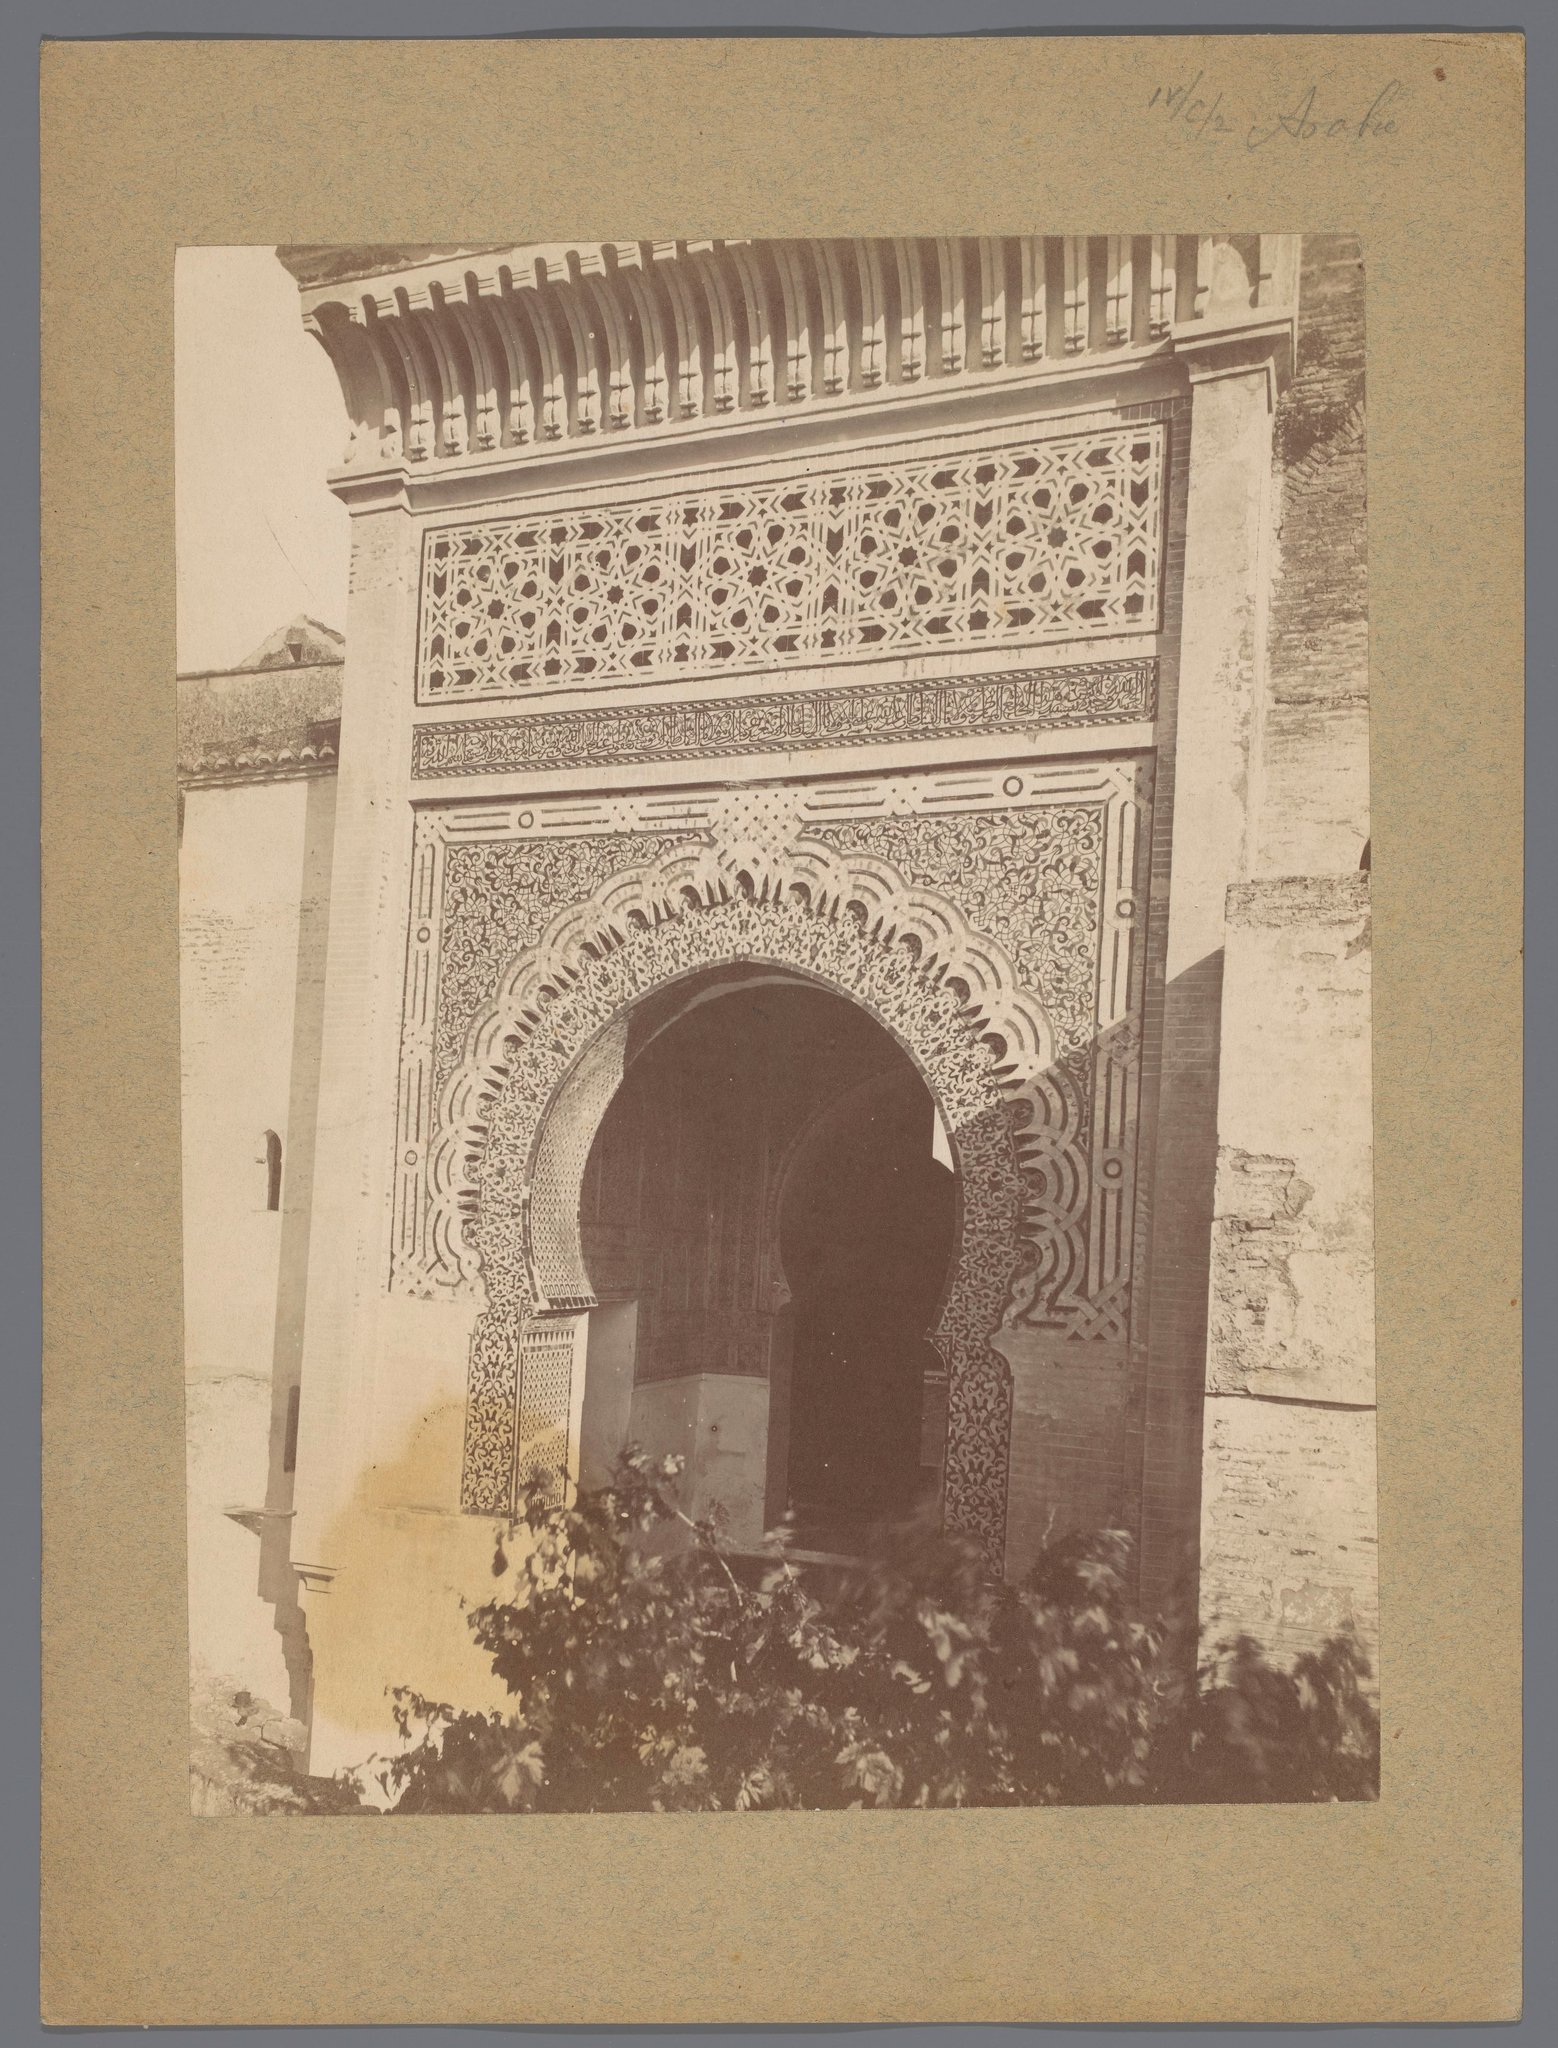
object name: photograph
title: Portaal in Moorse stijl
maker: Anonymous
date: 1850-1900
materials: cardboard, photographic support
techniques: albumen print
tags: parts of church exterior and annexes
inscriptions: annotation: ‘IV/0/2 [...]’